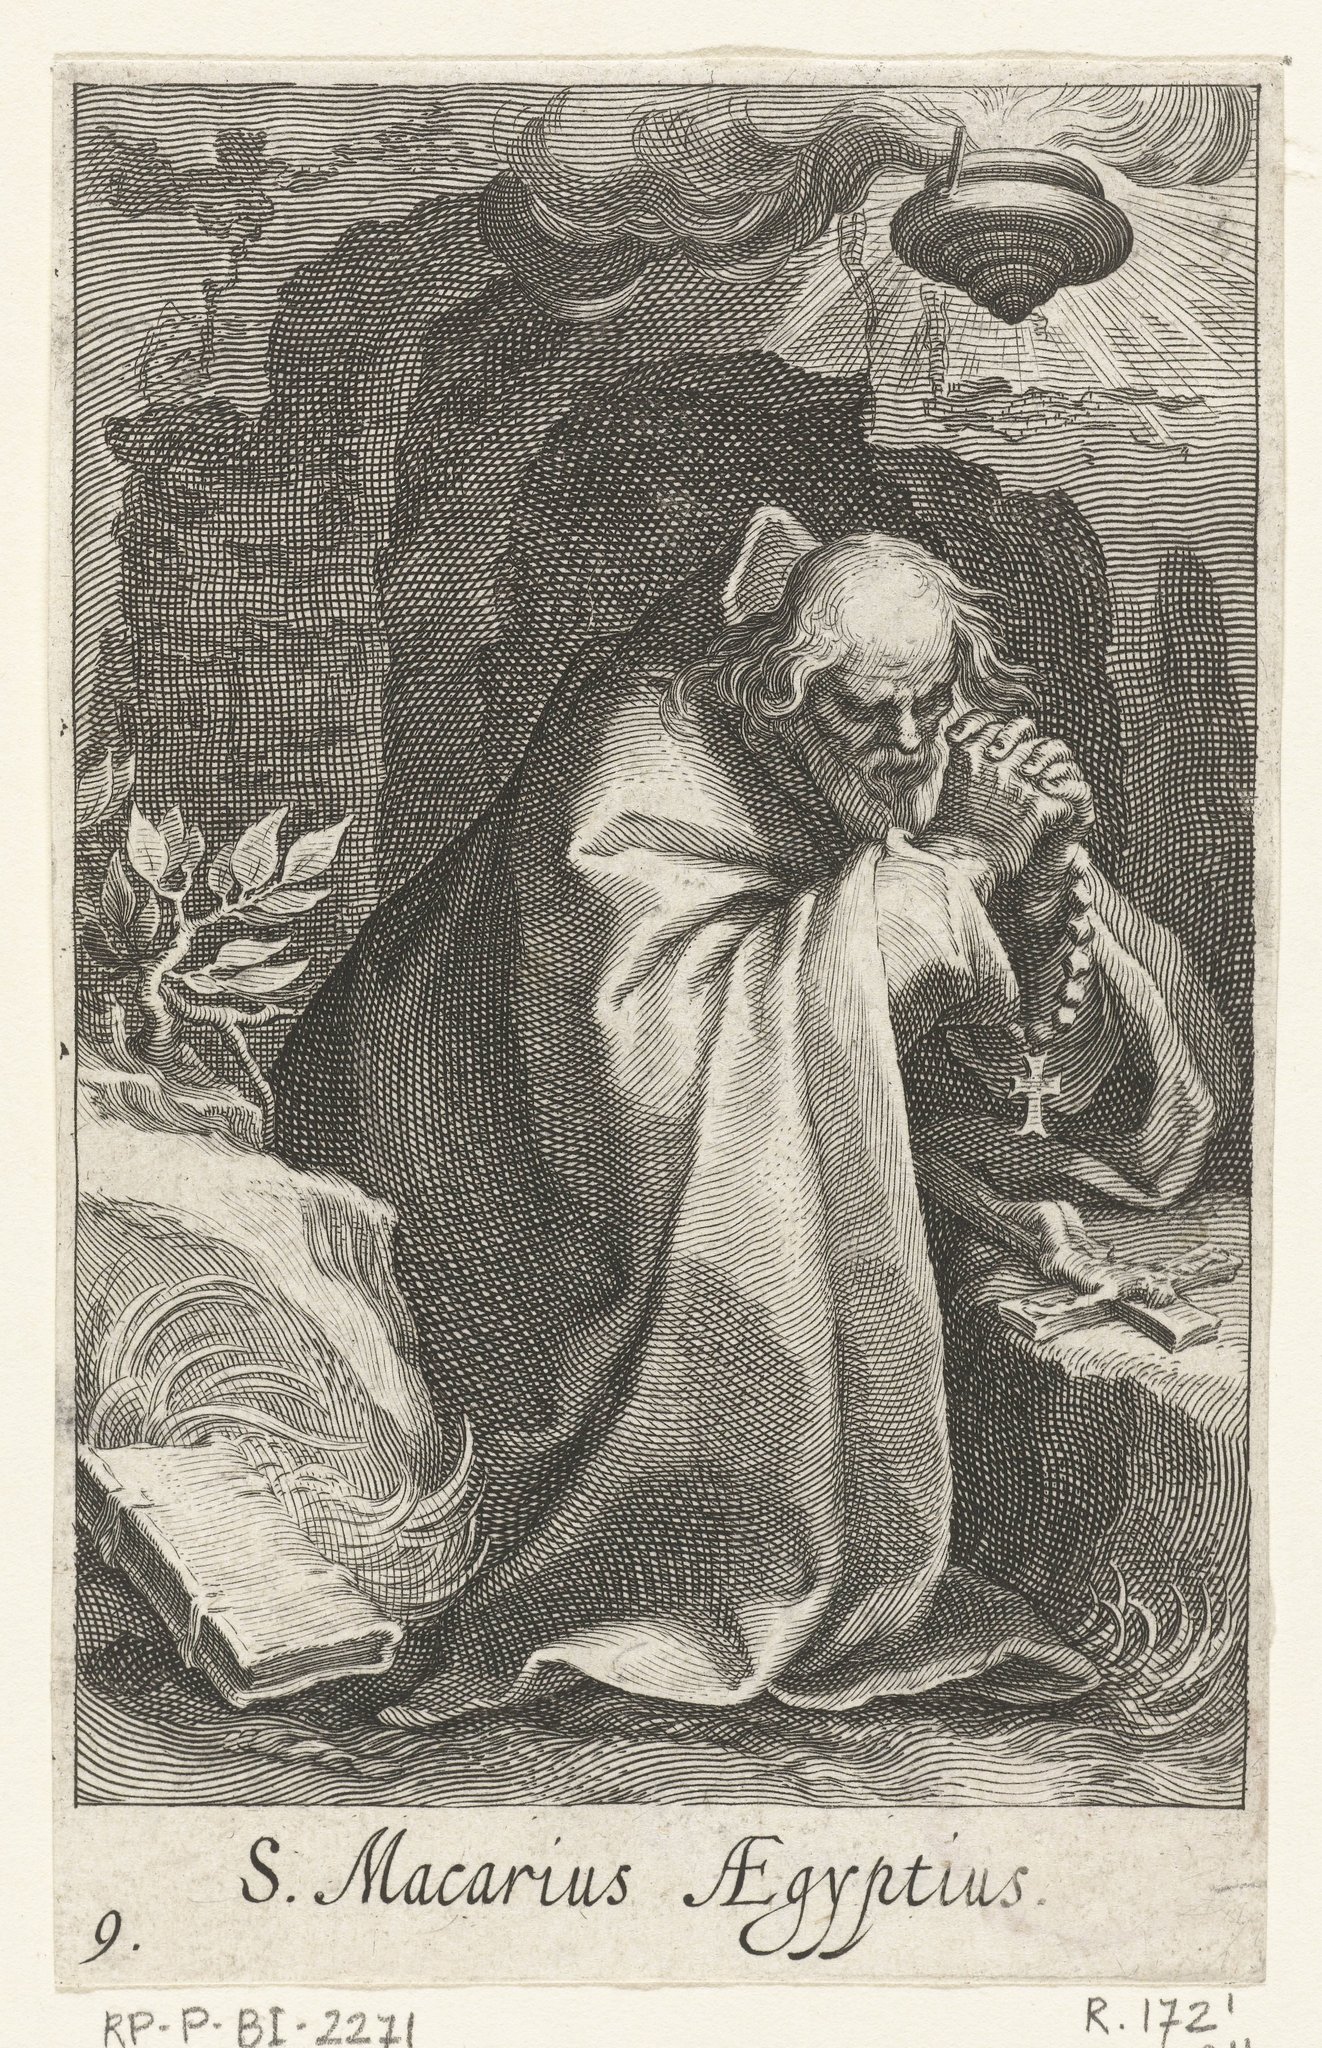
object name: book illustration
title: Sacra eremvs ascetarvm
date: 1590-1612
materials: paper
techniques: engraving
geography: amsterdam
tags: the hermit macarius of egypt (the elder, the great); possible attributes: t-shaped staff, skull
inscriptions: collector's mark: Lugt 240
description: Prent uit: Sacra eremus ascetarum, Antwerpen, Hendrick Aertssen, 1619. Eerste gebonden uitgave met in totaal vijftig prenten. Prent uit serie van vijfentwintig mannelijke kluizenaars. In 1612 verscheen een ongebonden editie maar op basis van de gewijzigde opschriften en samenstelling wordt aangenomen dat de prenten van de uitgave 1619 ook in 1612 of iets daarvoor gedrukt werden. Roethlisberger beschouwt de uitgave van 1619 als de eerste staat en de ongebonden editie van 1612 als de tweede staat (Roethlisberger 1993, p. 171, 172).